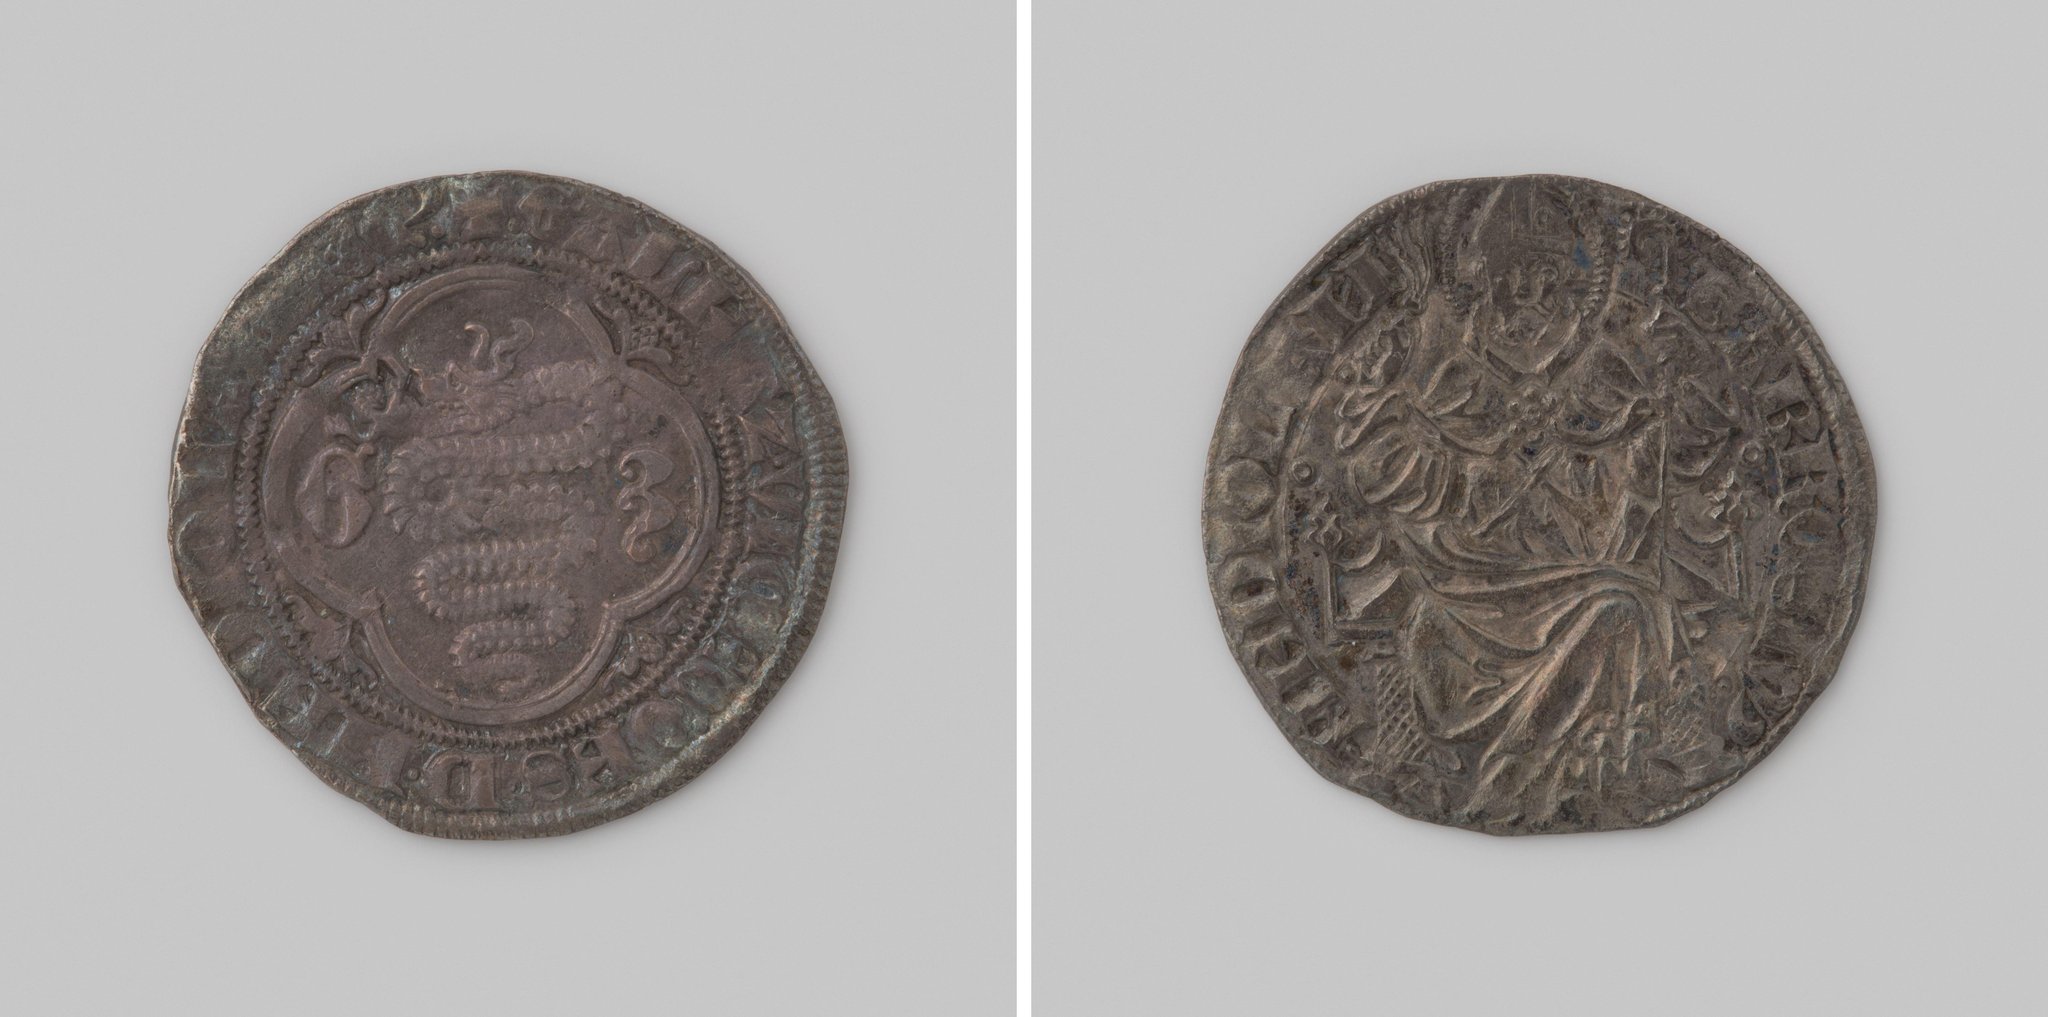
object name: coin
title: Pegione uit Milaan van Galeazzo II Visconti, 1354-1378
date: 1354-1378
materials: silver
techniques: striking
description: Zilveren munt. Voorzijde: binnen een vierpas tussen twee Gotische letters het wapen van Milaan. Keerzijde: gezeten bisschop met staf en andere attributen.